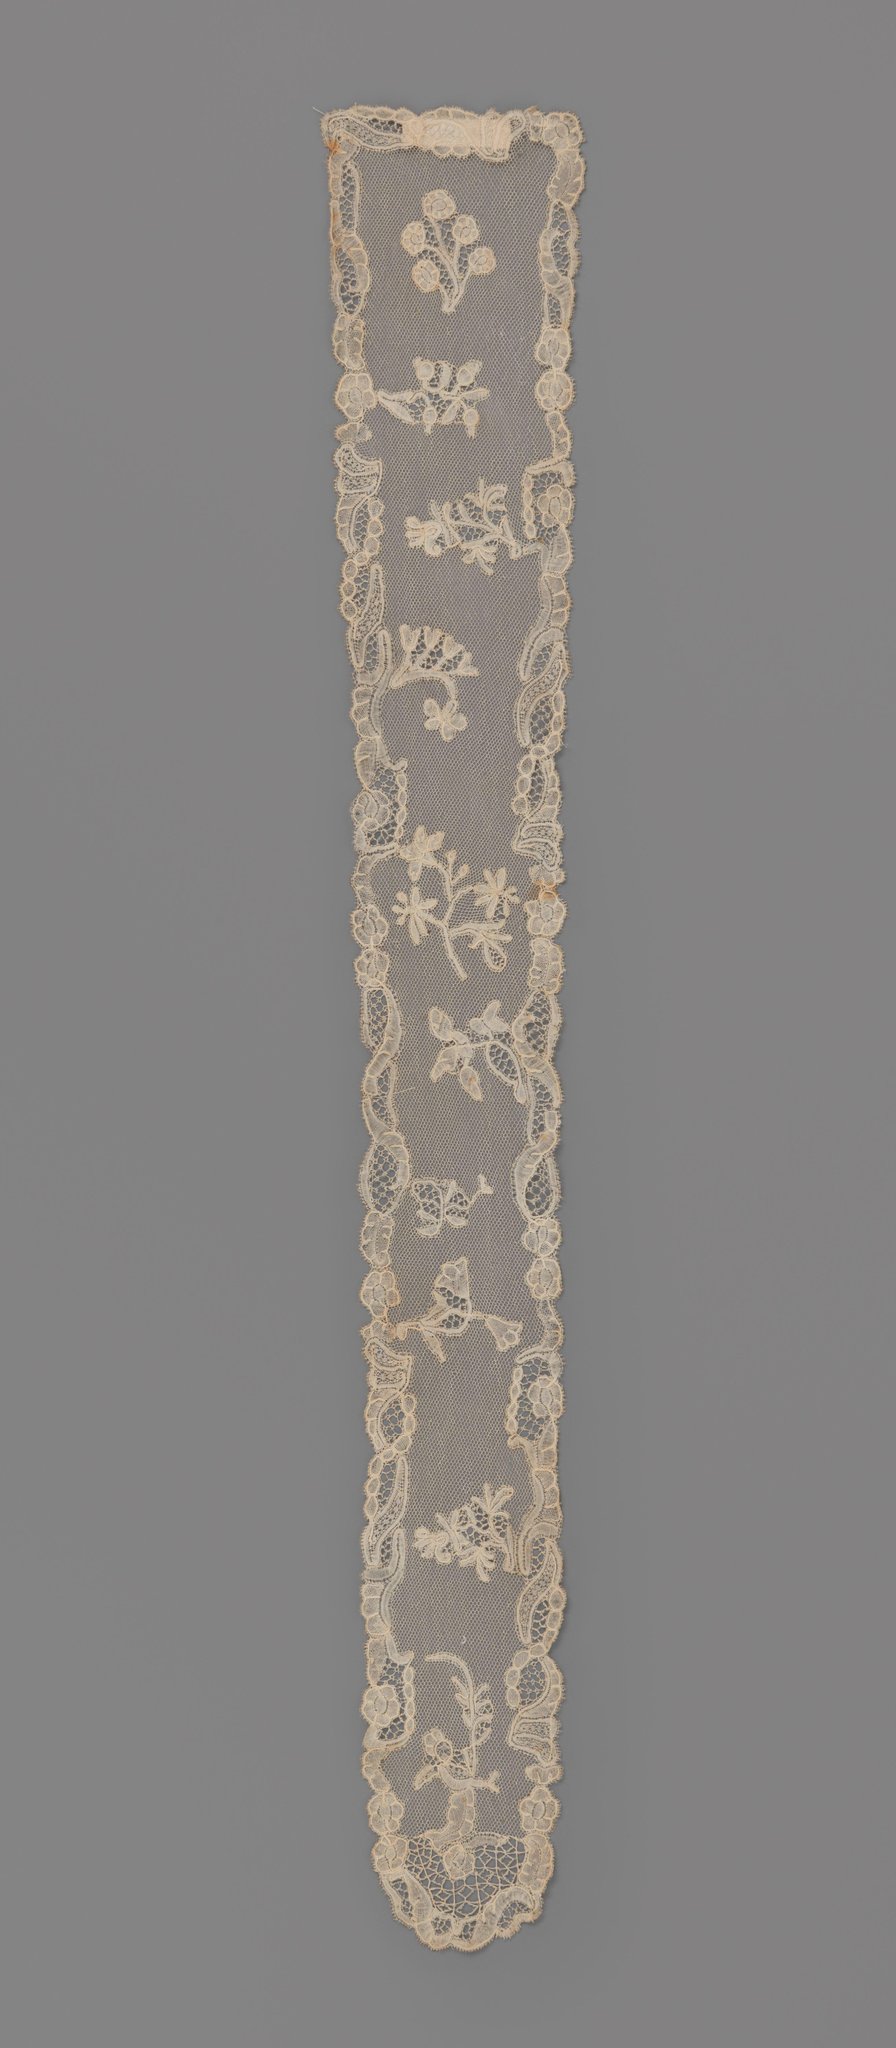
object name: lappet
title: Mutsenslip van Devonshirekant met een engel met palmtak aan het uiteinde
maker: Anonymous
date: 1775-1800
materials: linen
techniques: lace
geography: england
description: Mutsenslip van Devonshirekant met een engel met palmtak aan het ronde uiteinde. De overige decoratie bestaat uit bloemen en bloemtakken. De barbe is onregelmatig geschulpt en is geheel voorzien van een picotrand.